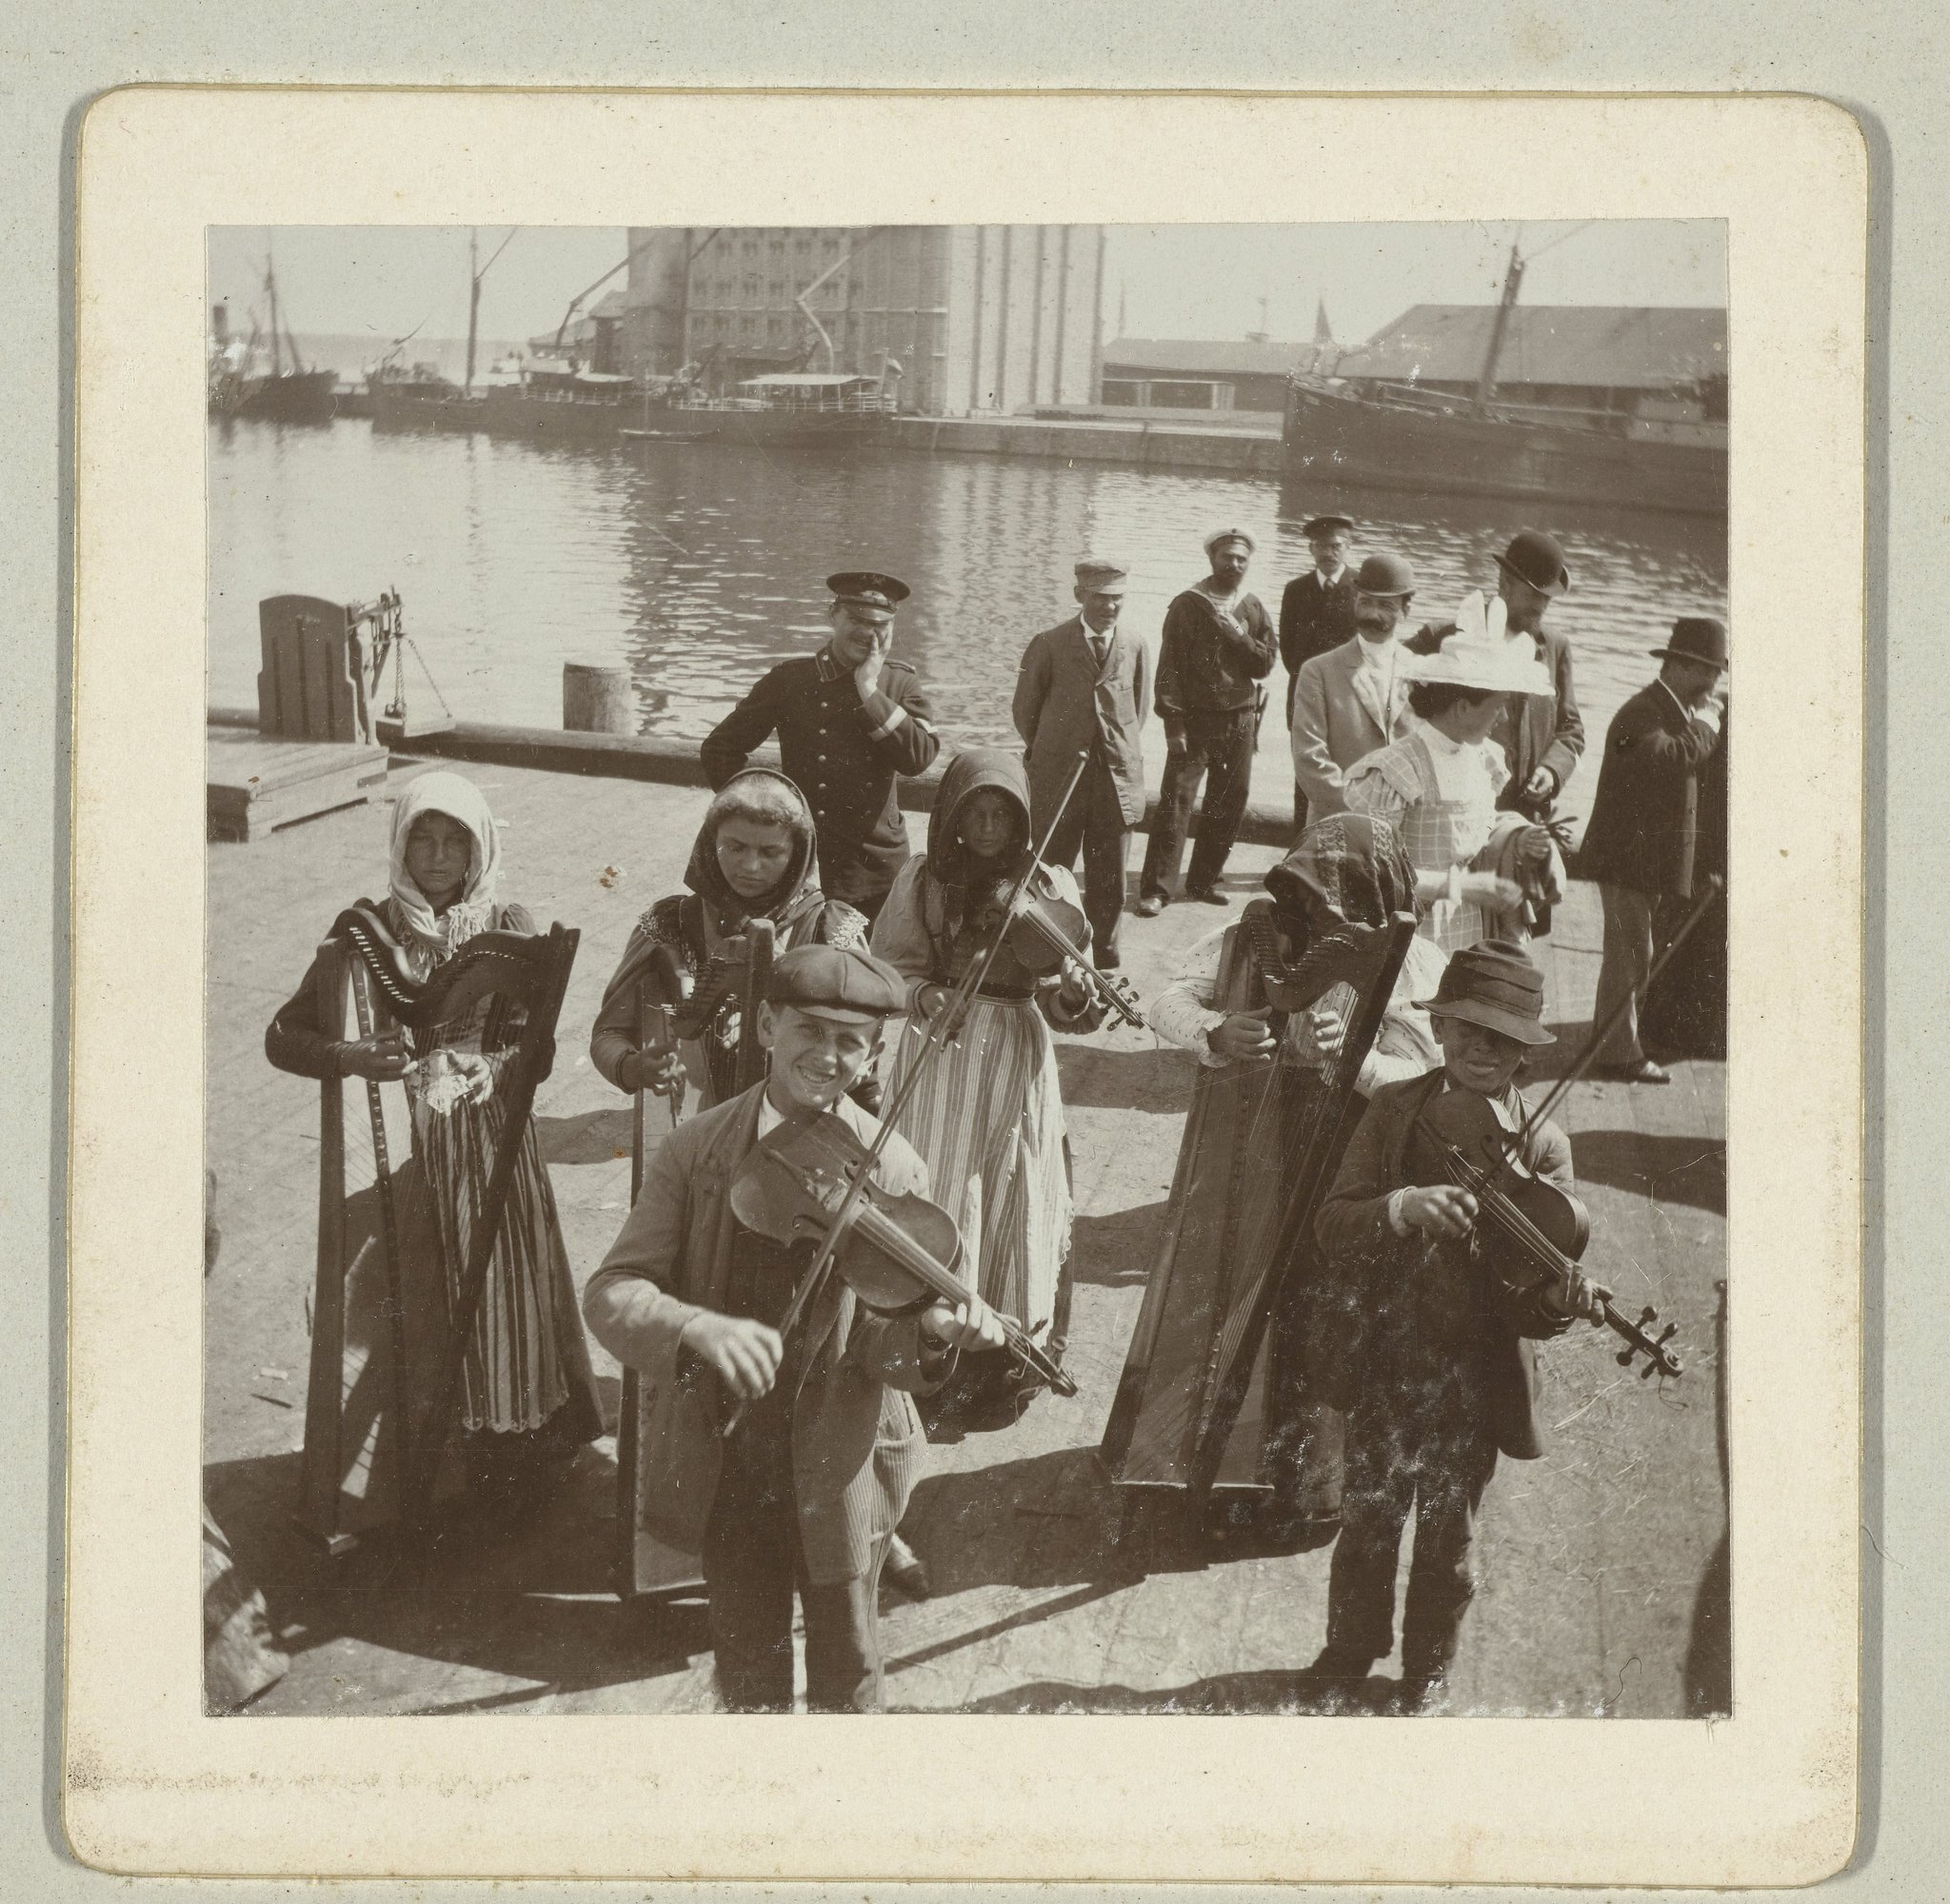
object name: photograph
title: Helsingfors Finland, kinderen spelende bij de boot, Norra Fnland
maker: henry pauw van wieldrecht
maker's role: fotograaf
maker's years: 1863-1912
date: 1898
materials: paper, photographic support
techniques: albumen print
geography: helsinki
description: Een groep kinderen spelend op muziekinstrumenten bij het afmeren van de Norra Finkland.